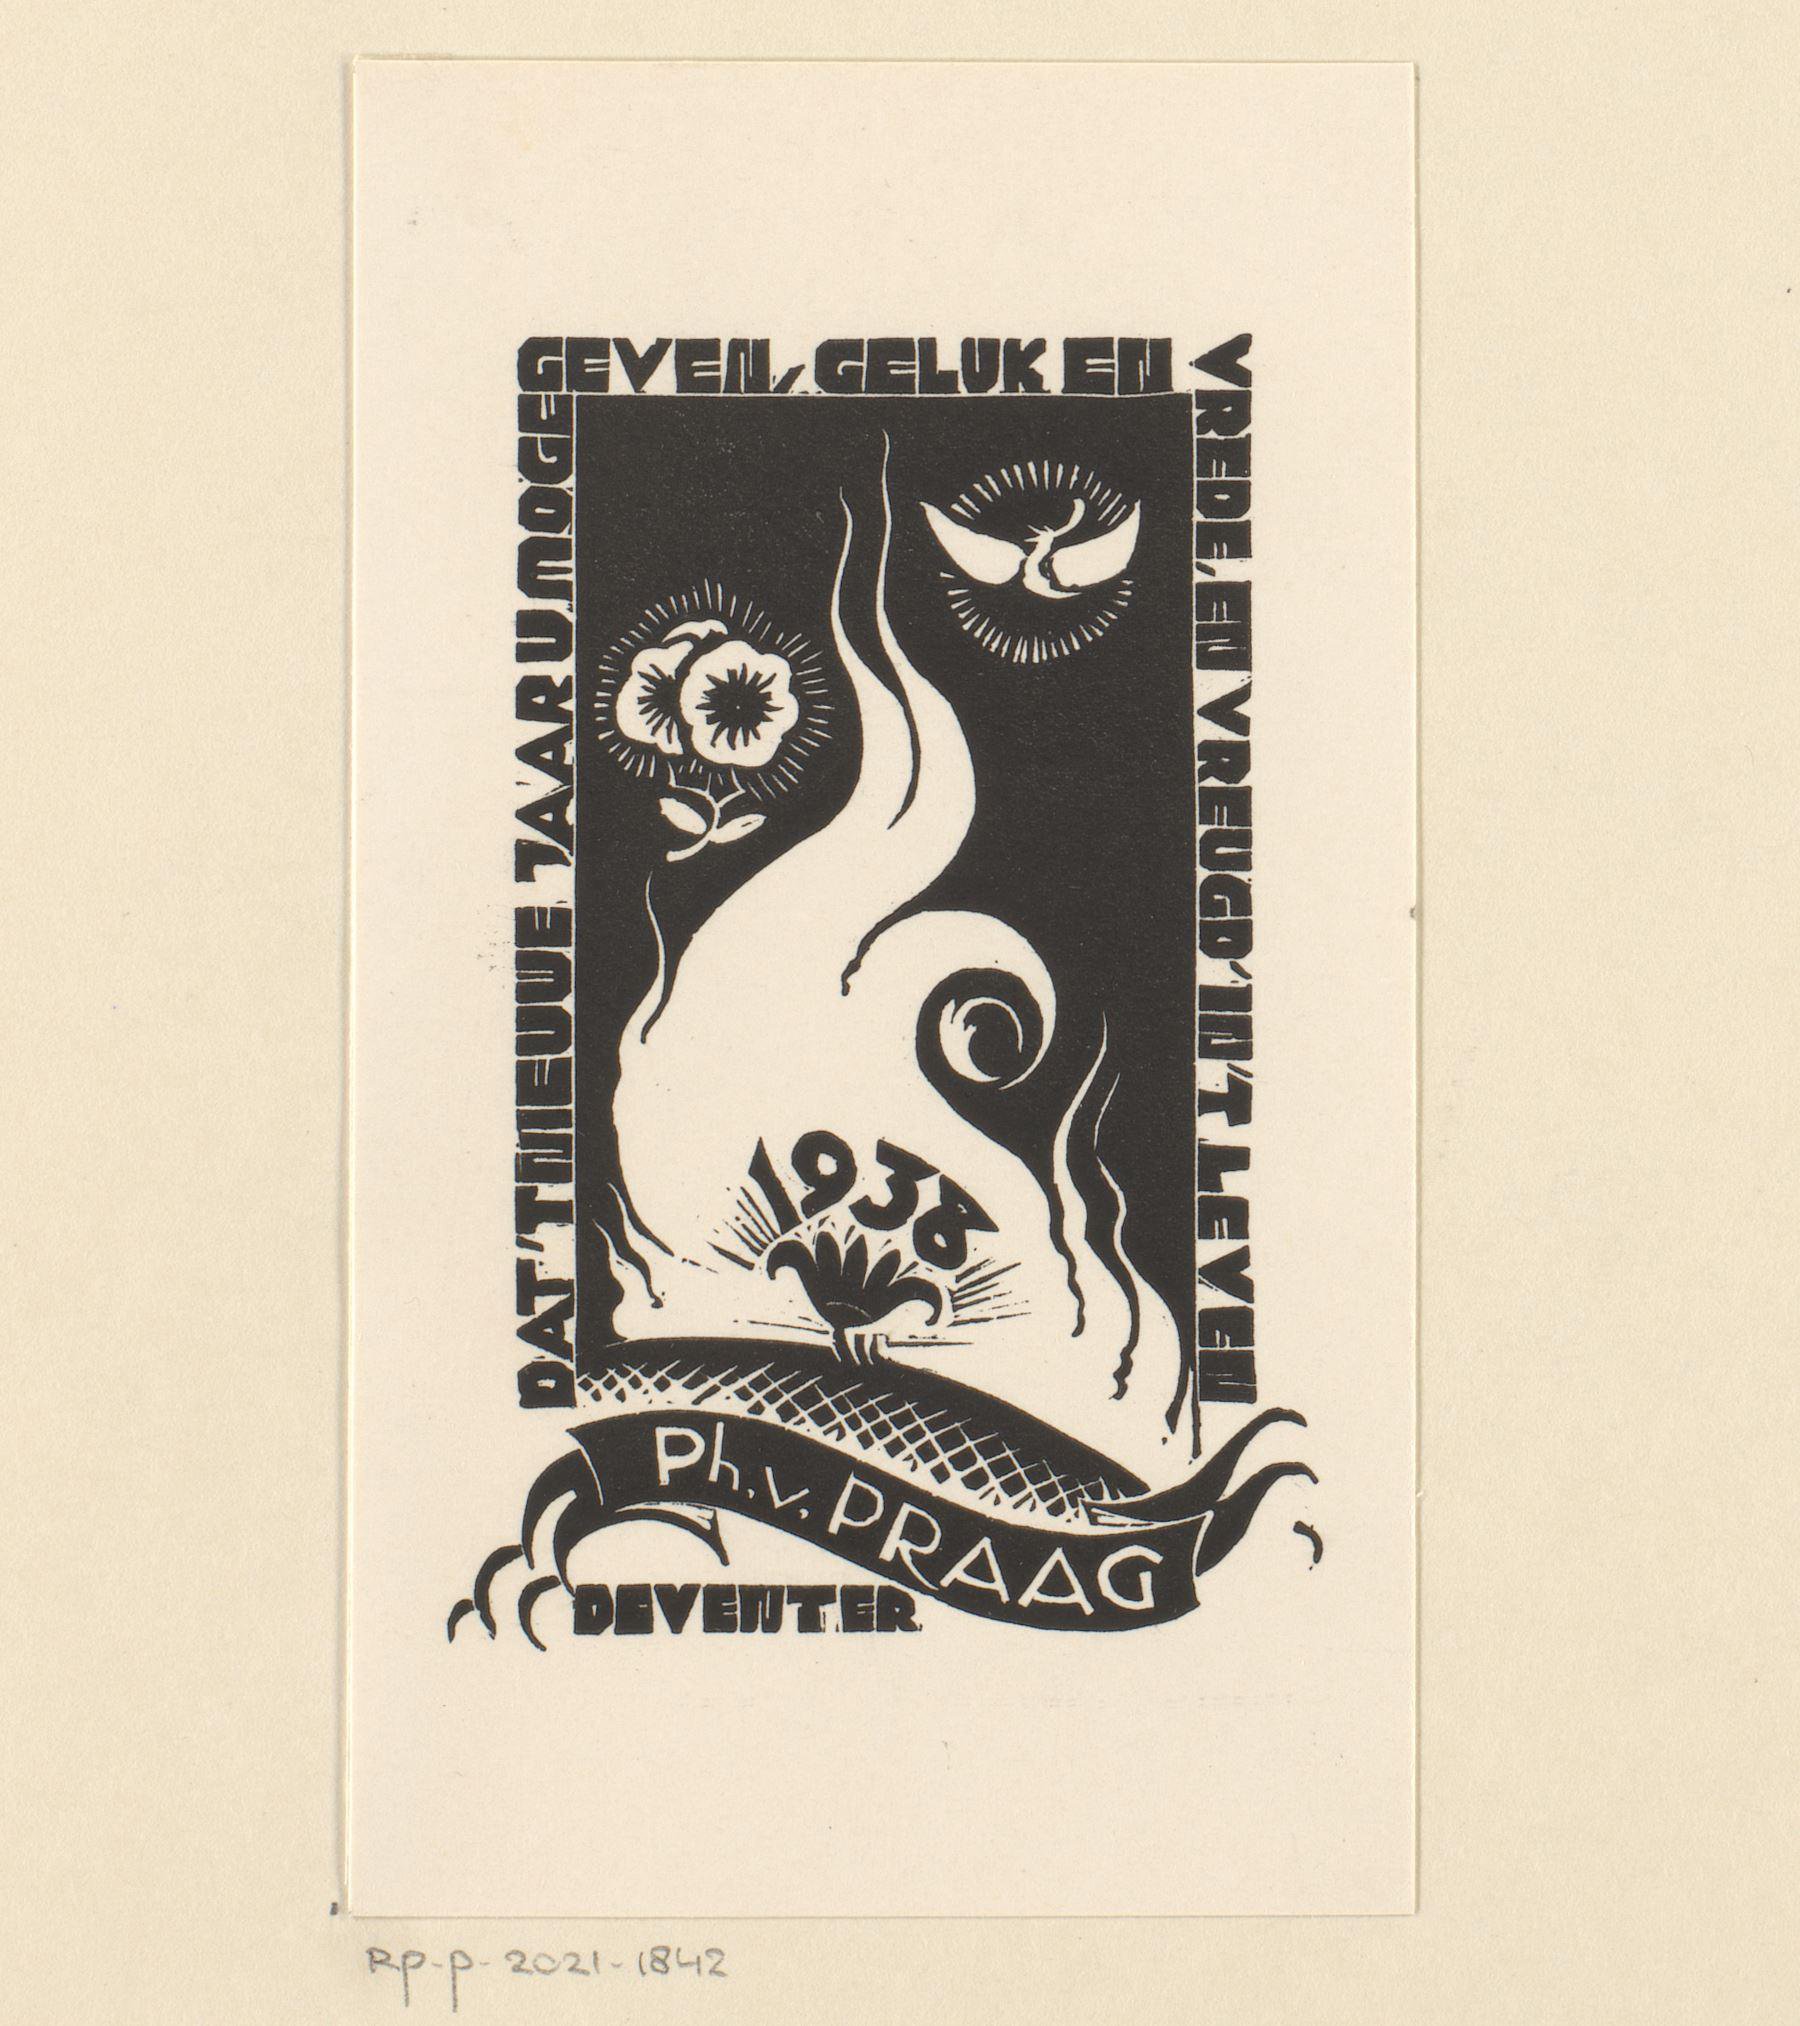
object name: easter card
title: Paaskaart van Philip van Praag voor 1938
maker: philip van praag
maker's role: draughtsman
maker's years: 1887-1942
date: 1938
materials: paper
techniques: linocut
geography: deventer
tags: flowers, holy ghost as a dove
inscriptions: date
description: Paaskaart met bloemen en een duif in een stralenkrans. Rondom de afbeelding de tekst 'Dat 't nieuwe jaar u moge geven, geluk en vrede, en vreugd in 't leven'.